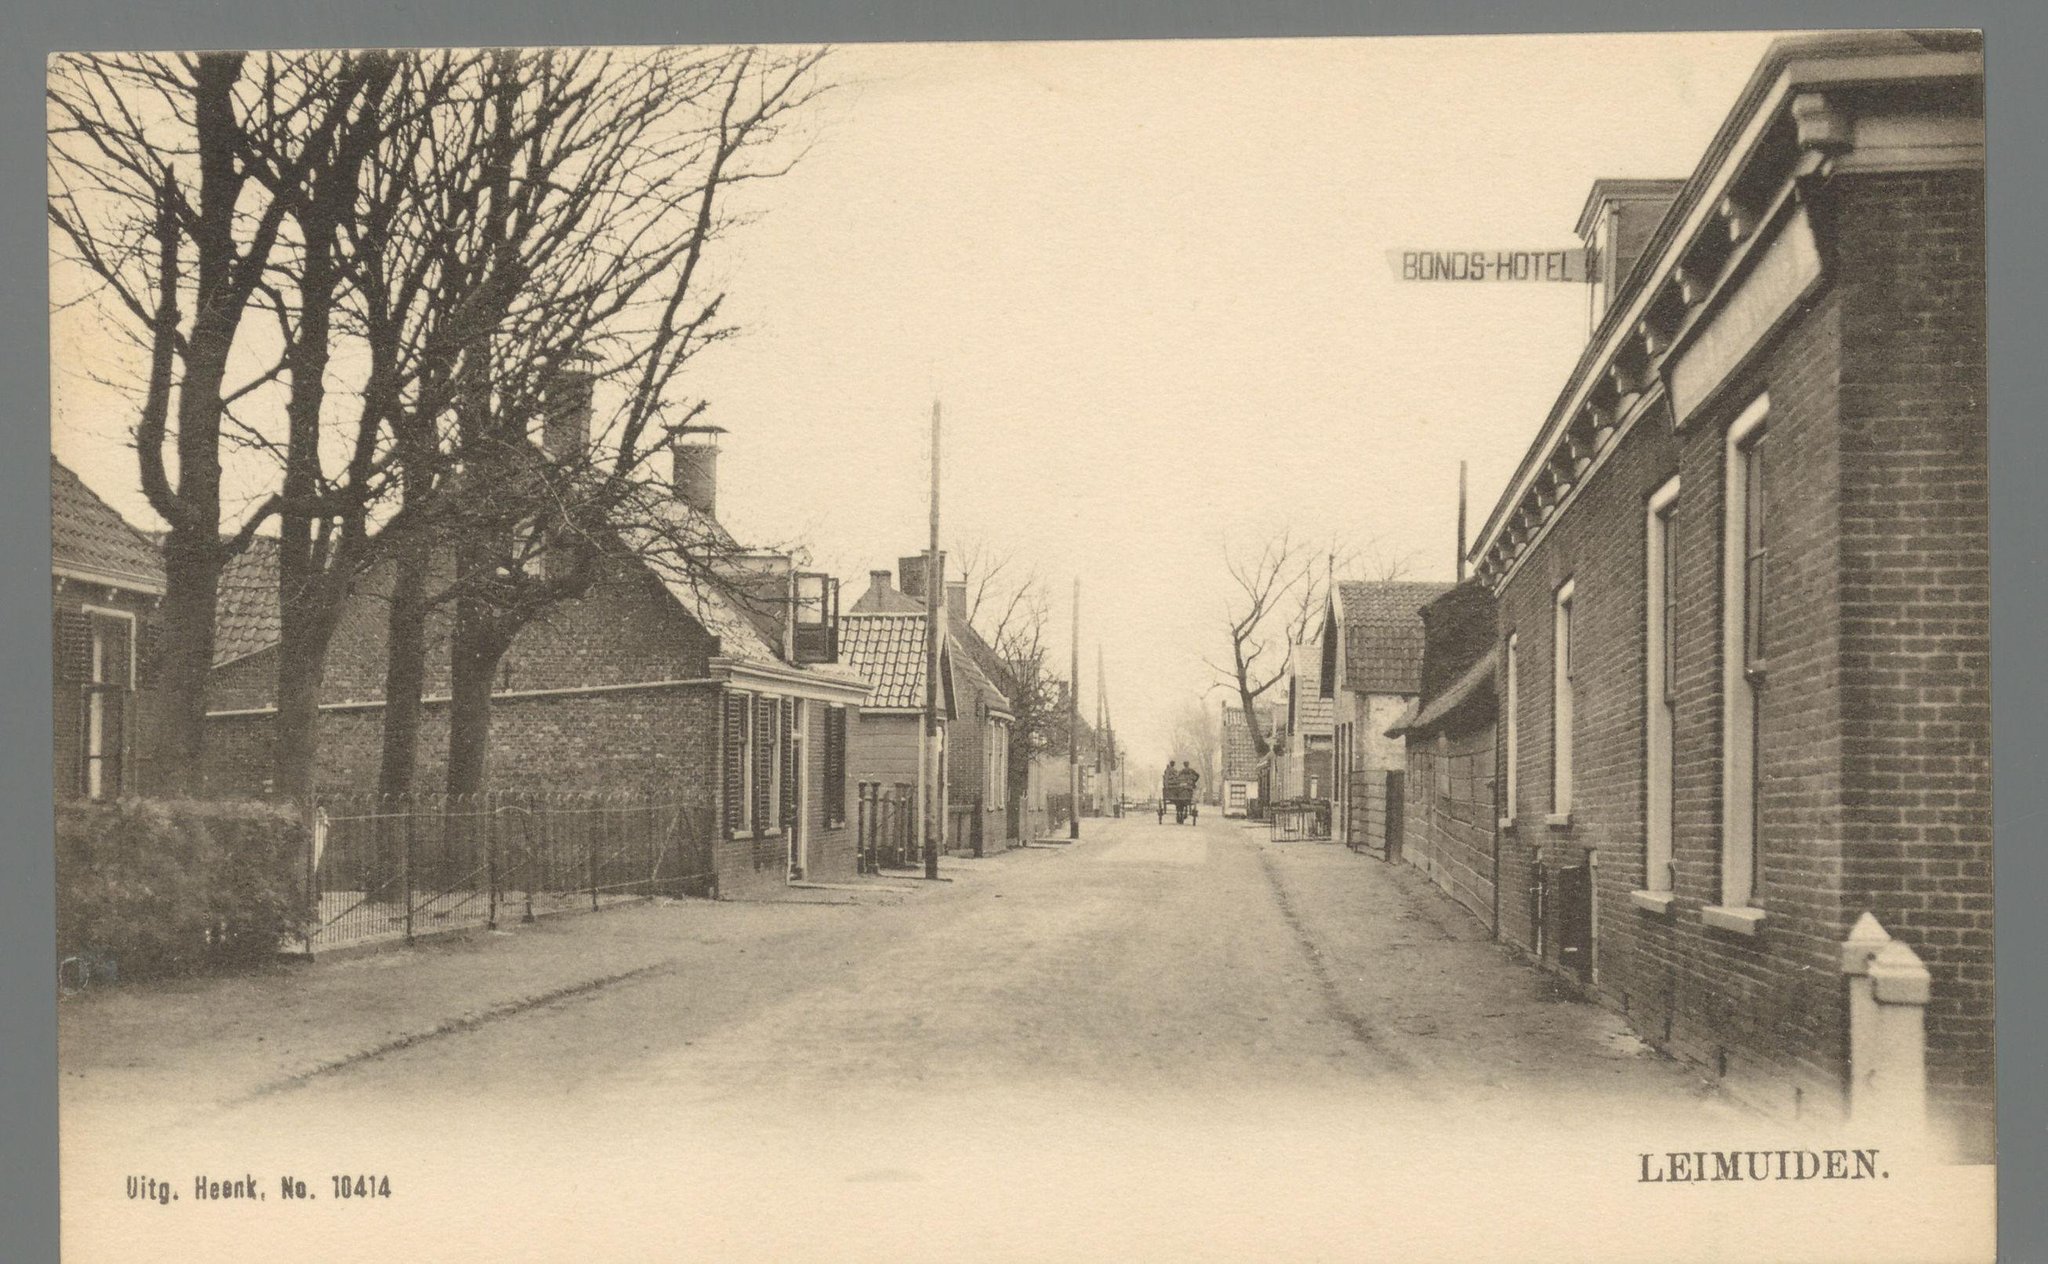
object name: ansichtkaart, prentbriefkaart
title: Leimuiden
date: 1897-1905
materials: cardboard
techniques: photograph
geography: leimuiden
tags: street, hotel, hostelry, inn